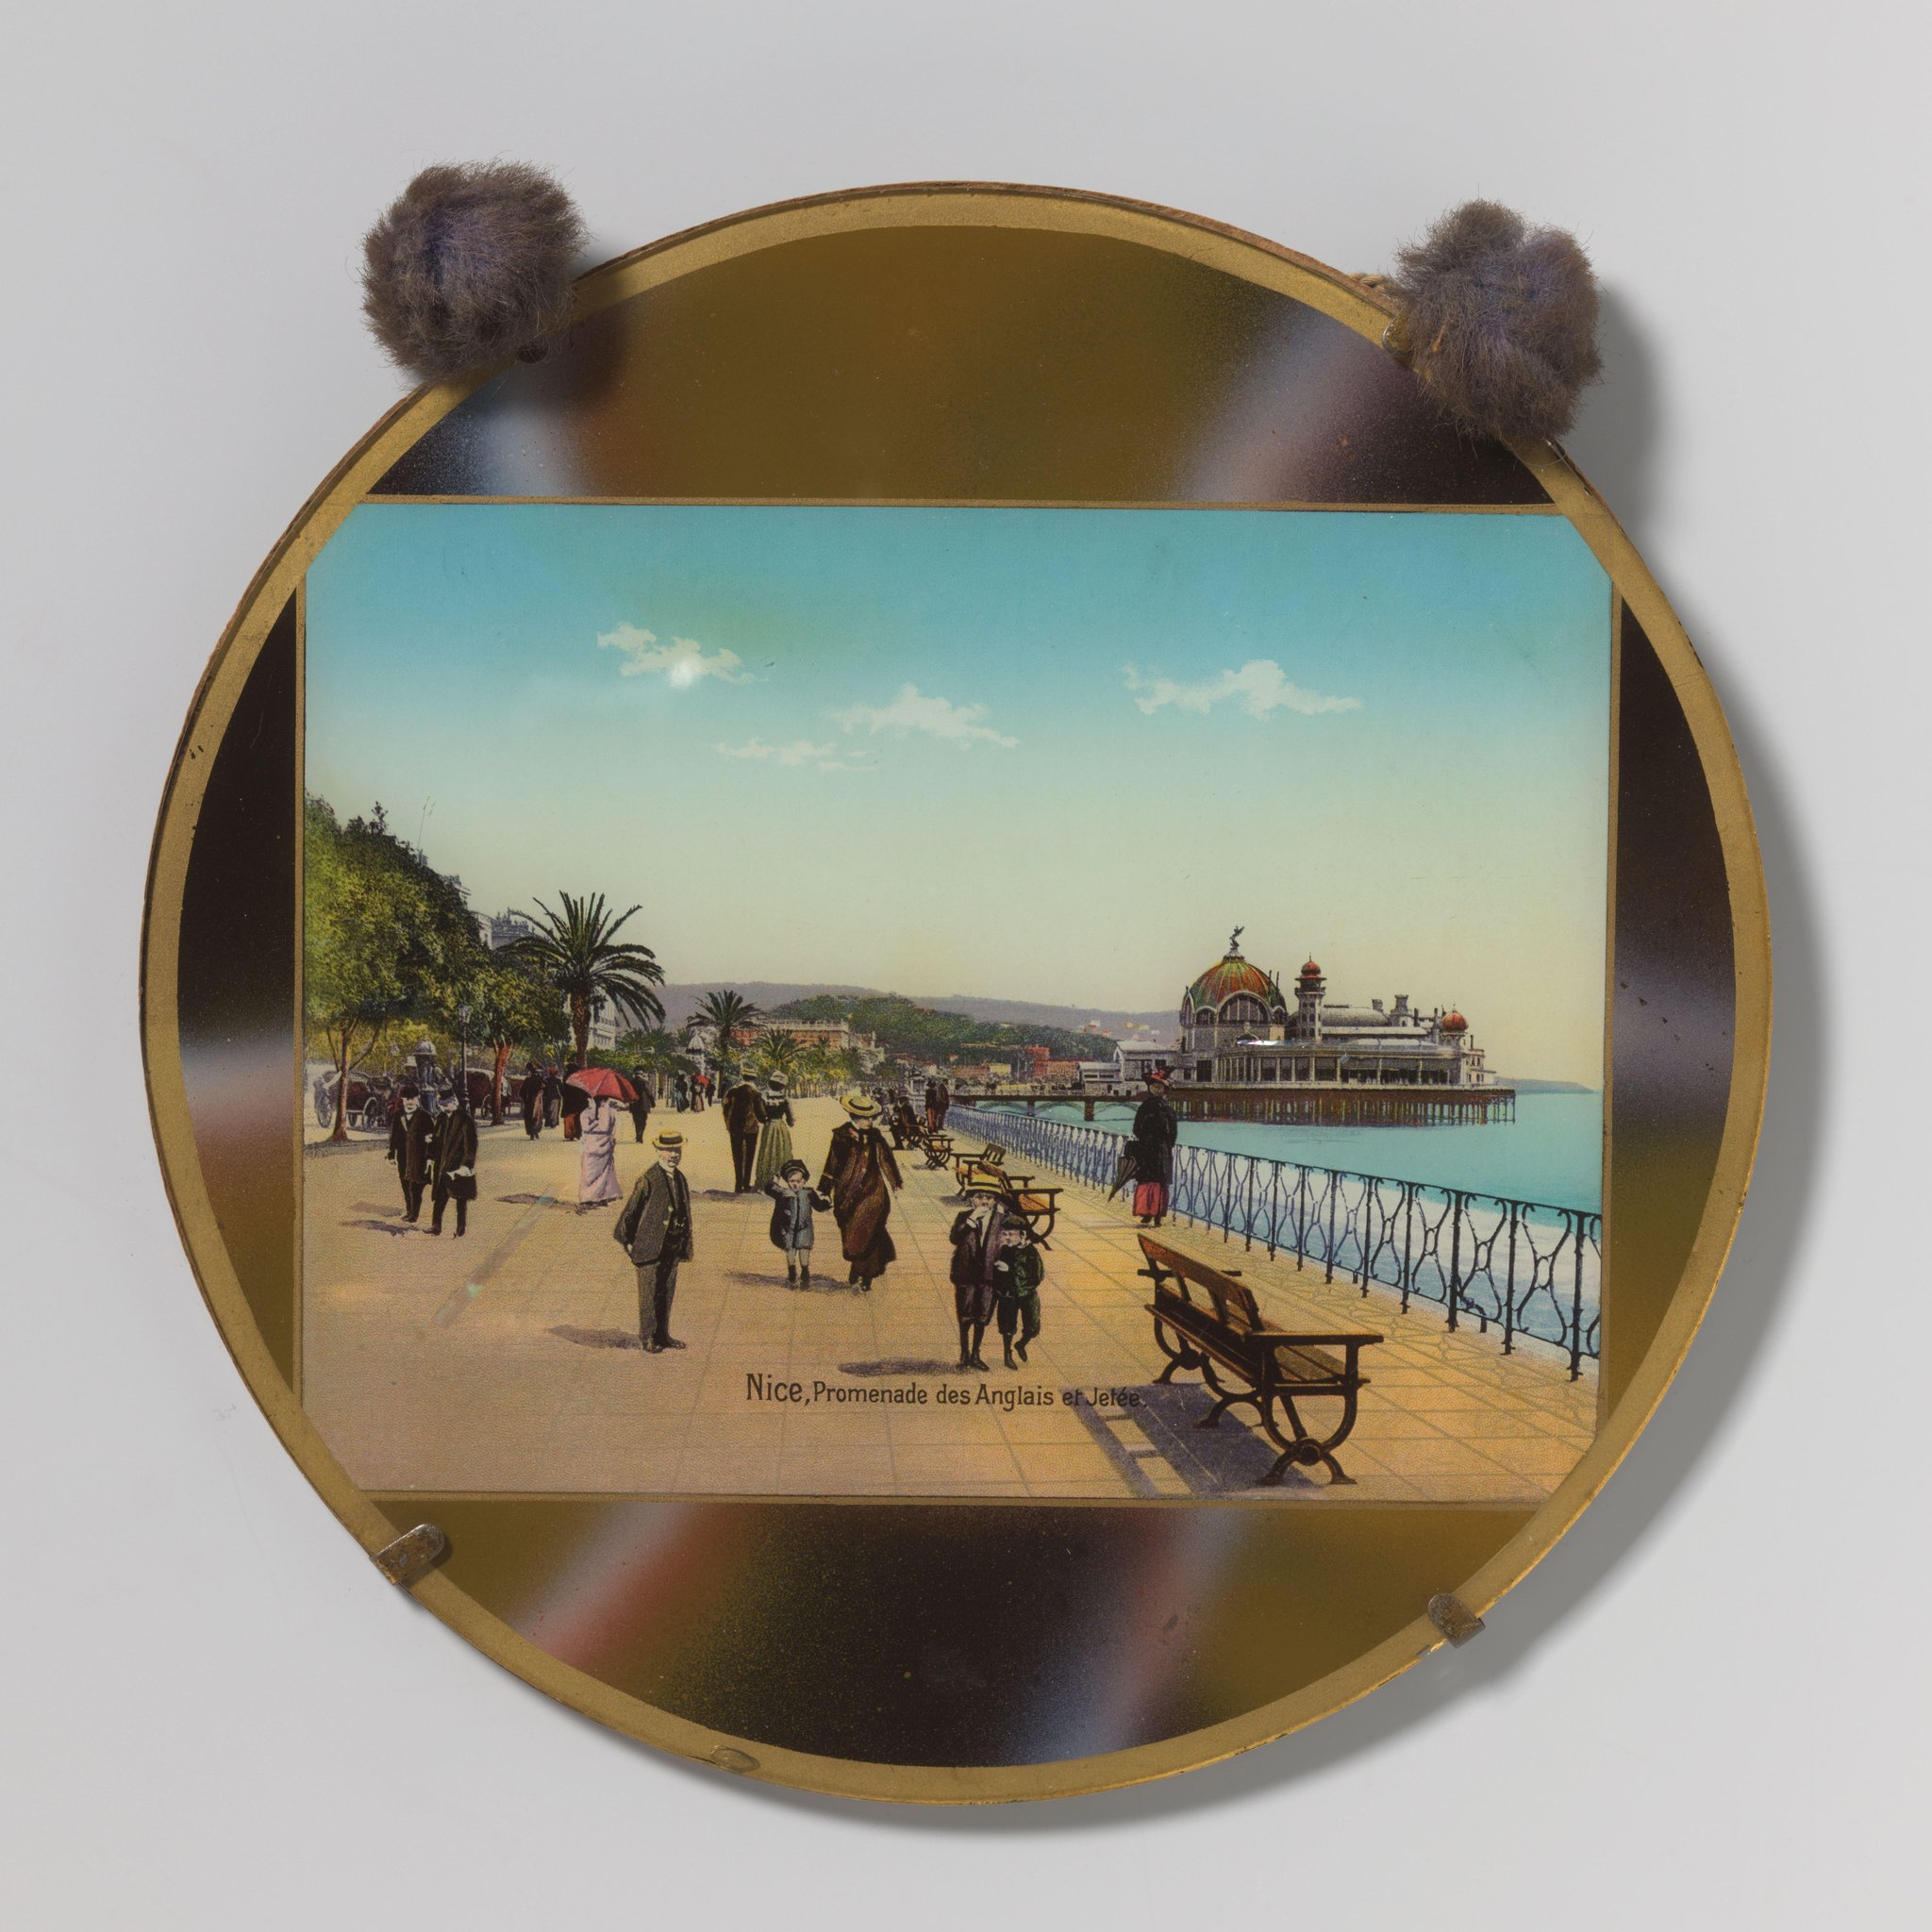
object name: frame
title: Gezicht op de Promenade des Anglais in Nice met rechts een pier met casino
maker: Anonymous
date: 1880-1900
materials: cardboard, glass, metal, paper, fiber, wool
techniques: lithograph, photolithography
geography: nice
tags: pier, quay, wharf, avenue, boulevard, promenade, esplanade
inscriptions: inscription: ‘Fabrication LL Française’